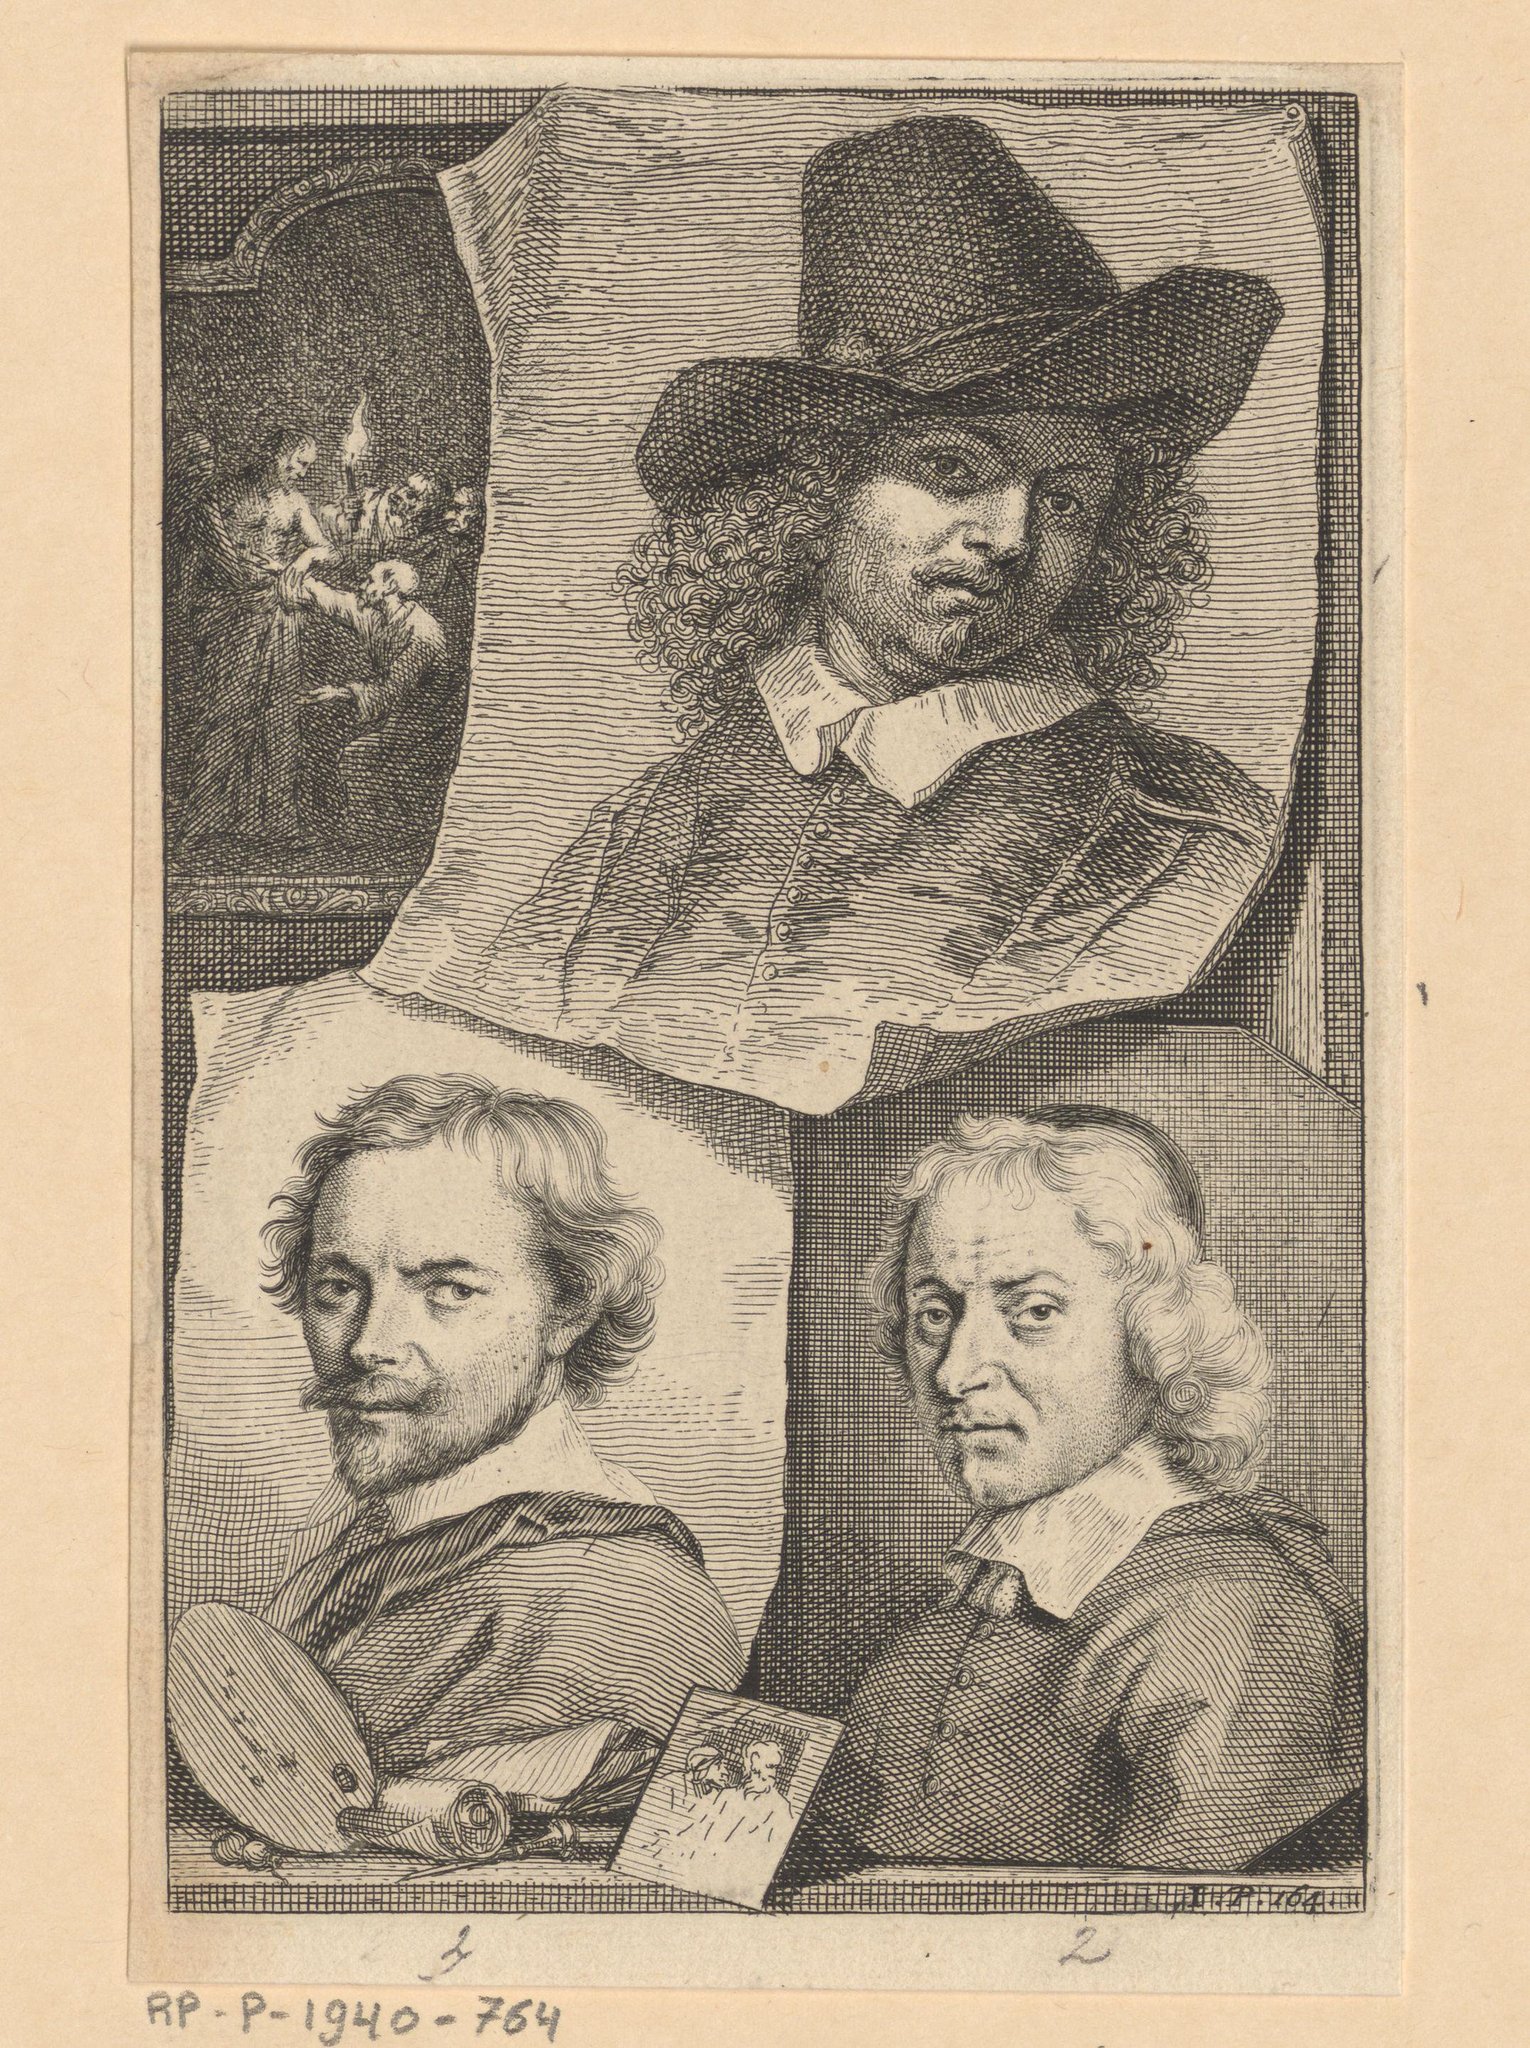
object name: book illustration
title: Portretten van Leonaert Bramer, Salomon de Bray en Dirk van Hoogstraten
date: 1753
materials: paper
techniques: engraving, etching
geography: the hague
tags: delft, leonaert bramer, antwerp, dordrecht, painter, print maker, dirk van hoogstraten, amsterdam, draughtsman, salomon de bray, historical persons, portrait, self-portrait of artist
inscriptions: collector's mark: Lugt 2228, collector's mark: Lugt 2760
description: Prent uit: Houbraken, Arnold. De groote schouburgh der Nederlantsche konstschilders en schilderessen (...). Den Haag: Jan Swart van Groningen, Cornelis Boucquet en Mattheus Gaillard, 1753, dl. 1. Vroegere staat verschenen in de eerste editie van 1718.